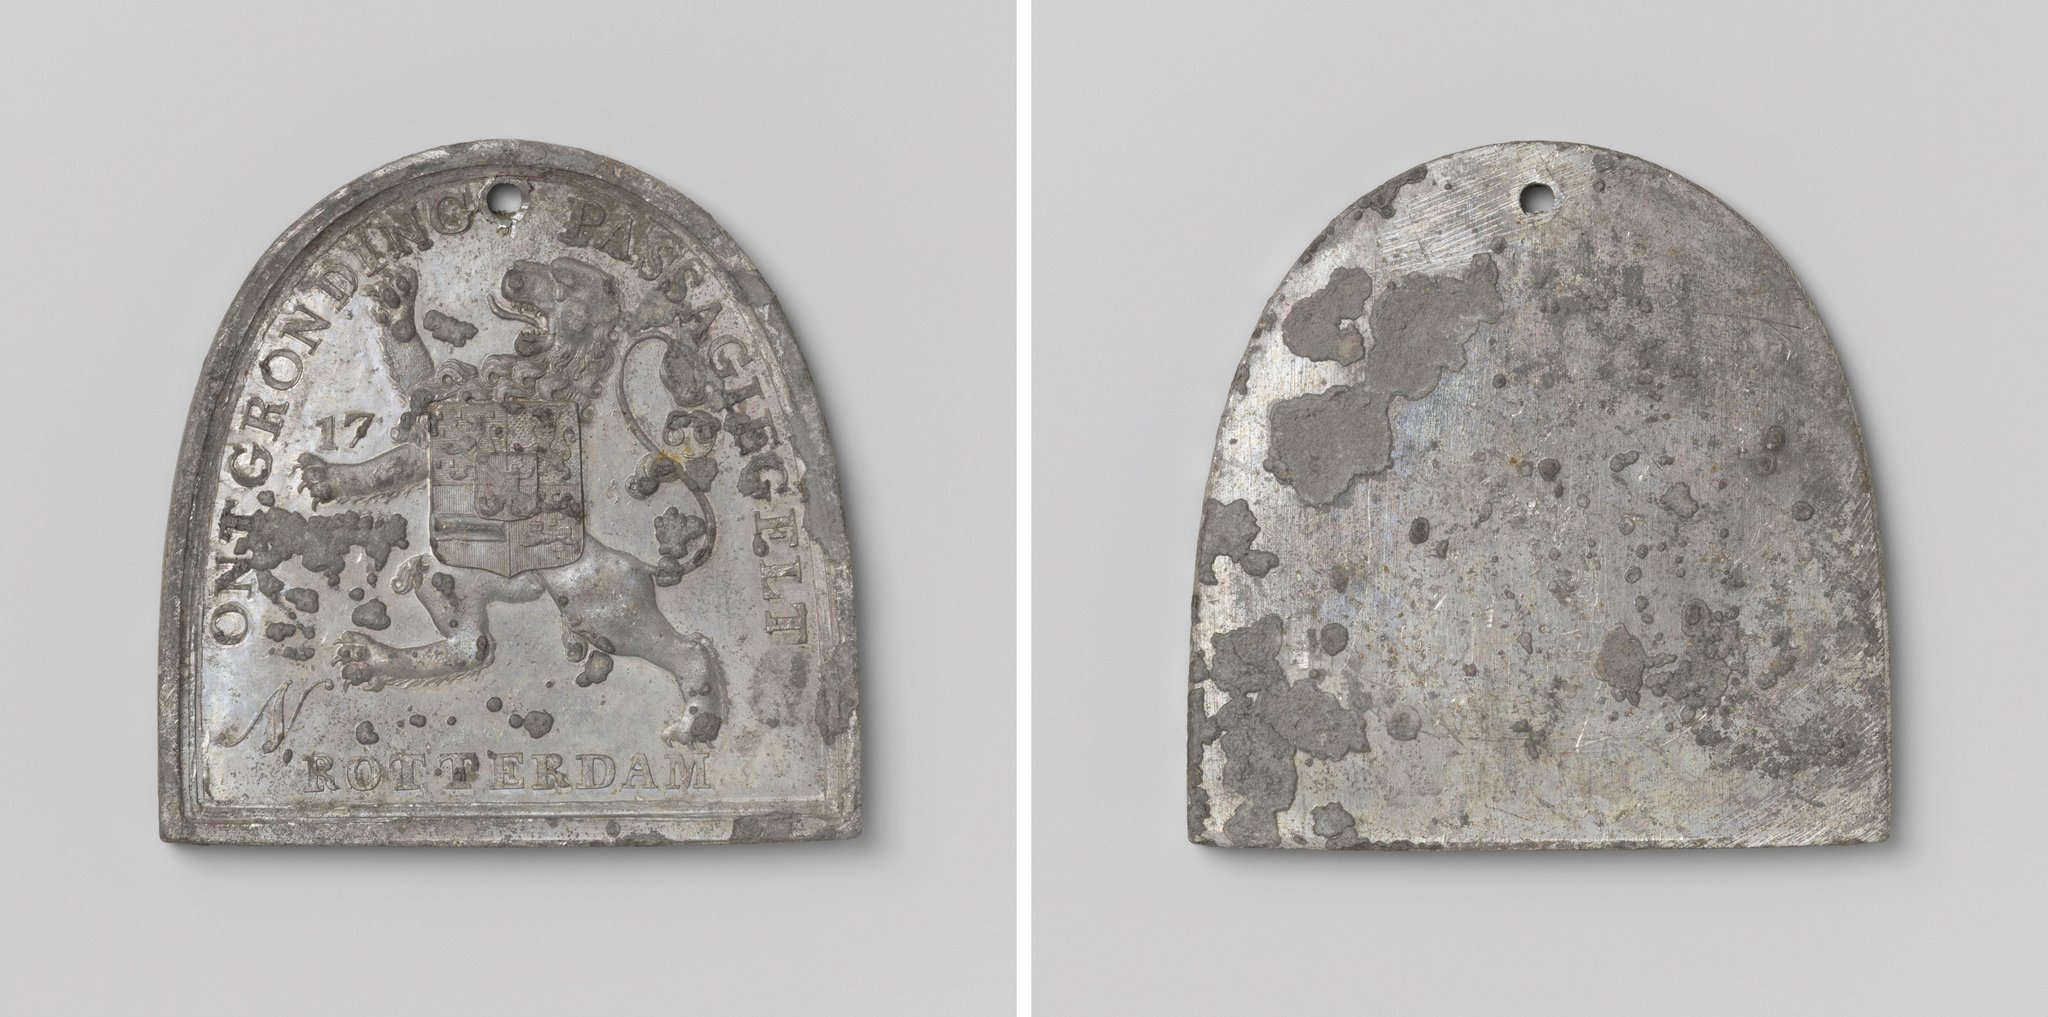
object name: ontgrondingspenning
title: Ontgronding te Rotterdam, penning bedoeld als bewijs voor turfdragers, -vullers of -tonners om turf in te mogen voeren uit de nieuw ontgronde venen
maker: Anonymous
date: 1769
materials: lead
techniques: casting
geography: rotterdam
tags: rotterdam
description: Eenzijdige loden penning met ronde boven- en rechthoekige onderzijde, en gat erin. Voorzijde: staande leeuw met wapenschild op borst tussen jaartal binnen omschrift. Keerzijde: blanco.